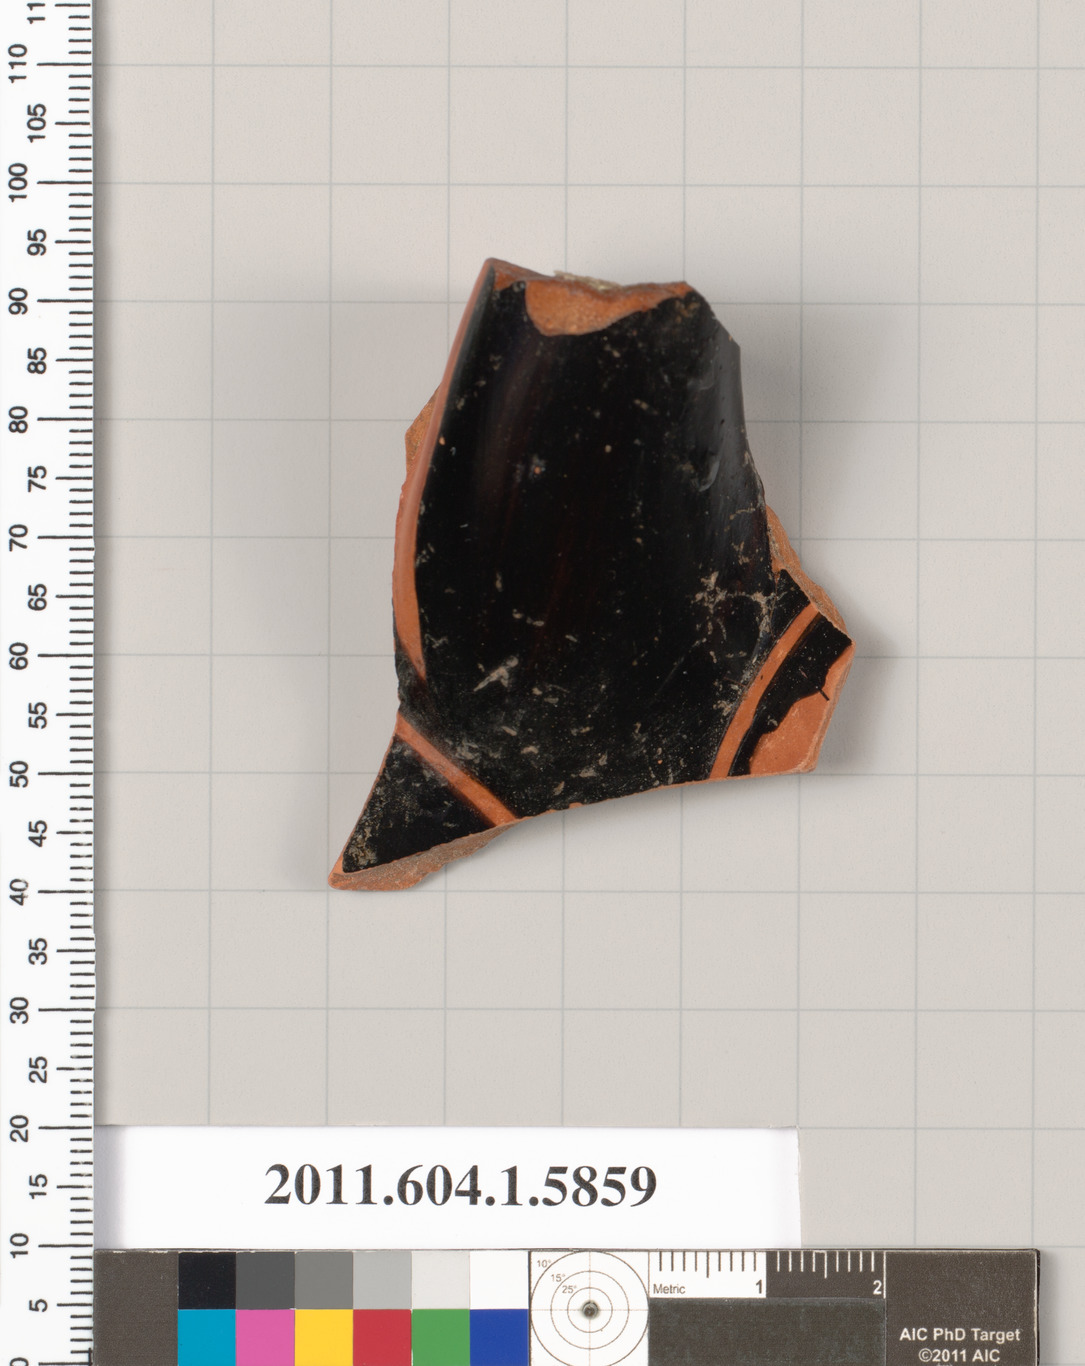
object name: kylix fragment, eye cup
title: Terracotta fragment of a kylix: eye-cup (drinking cup)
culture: greek, attic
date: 433-567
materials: terracotta